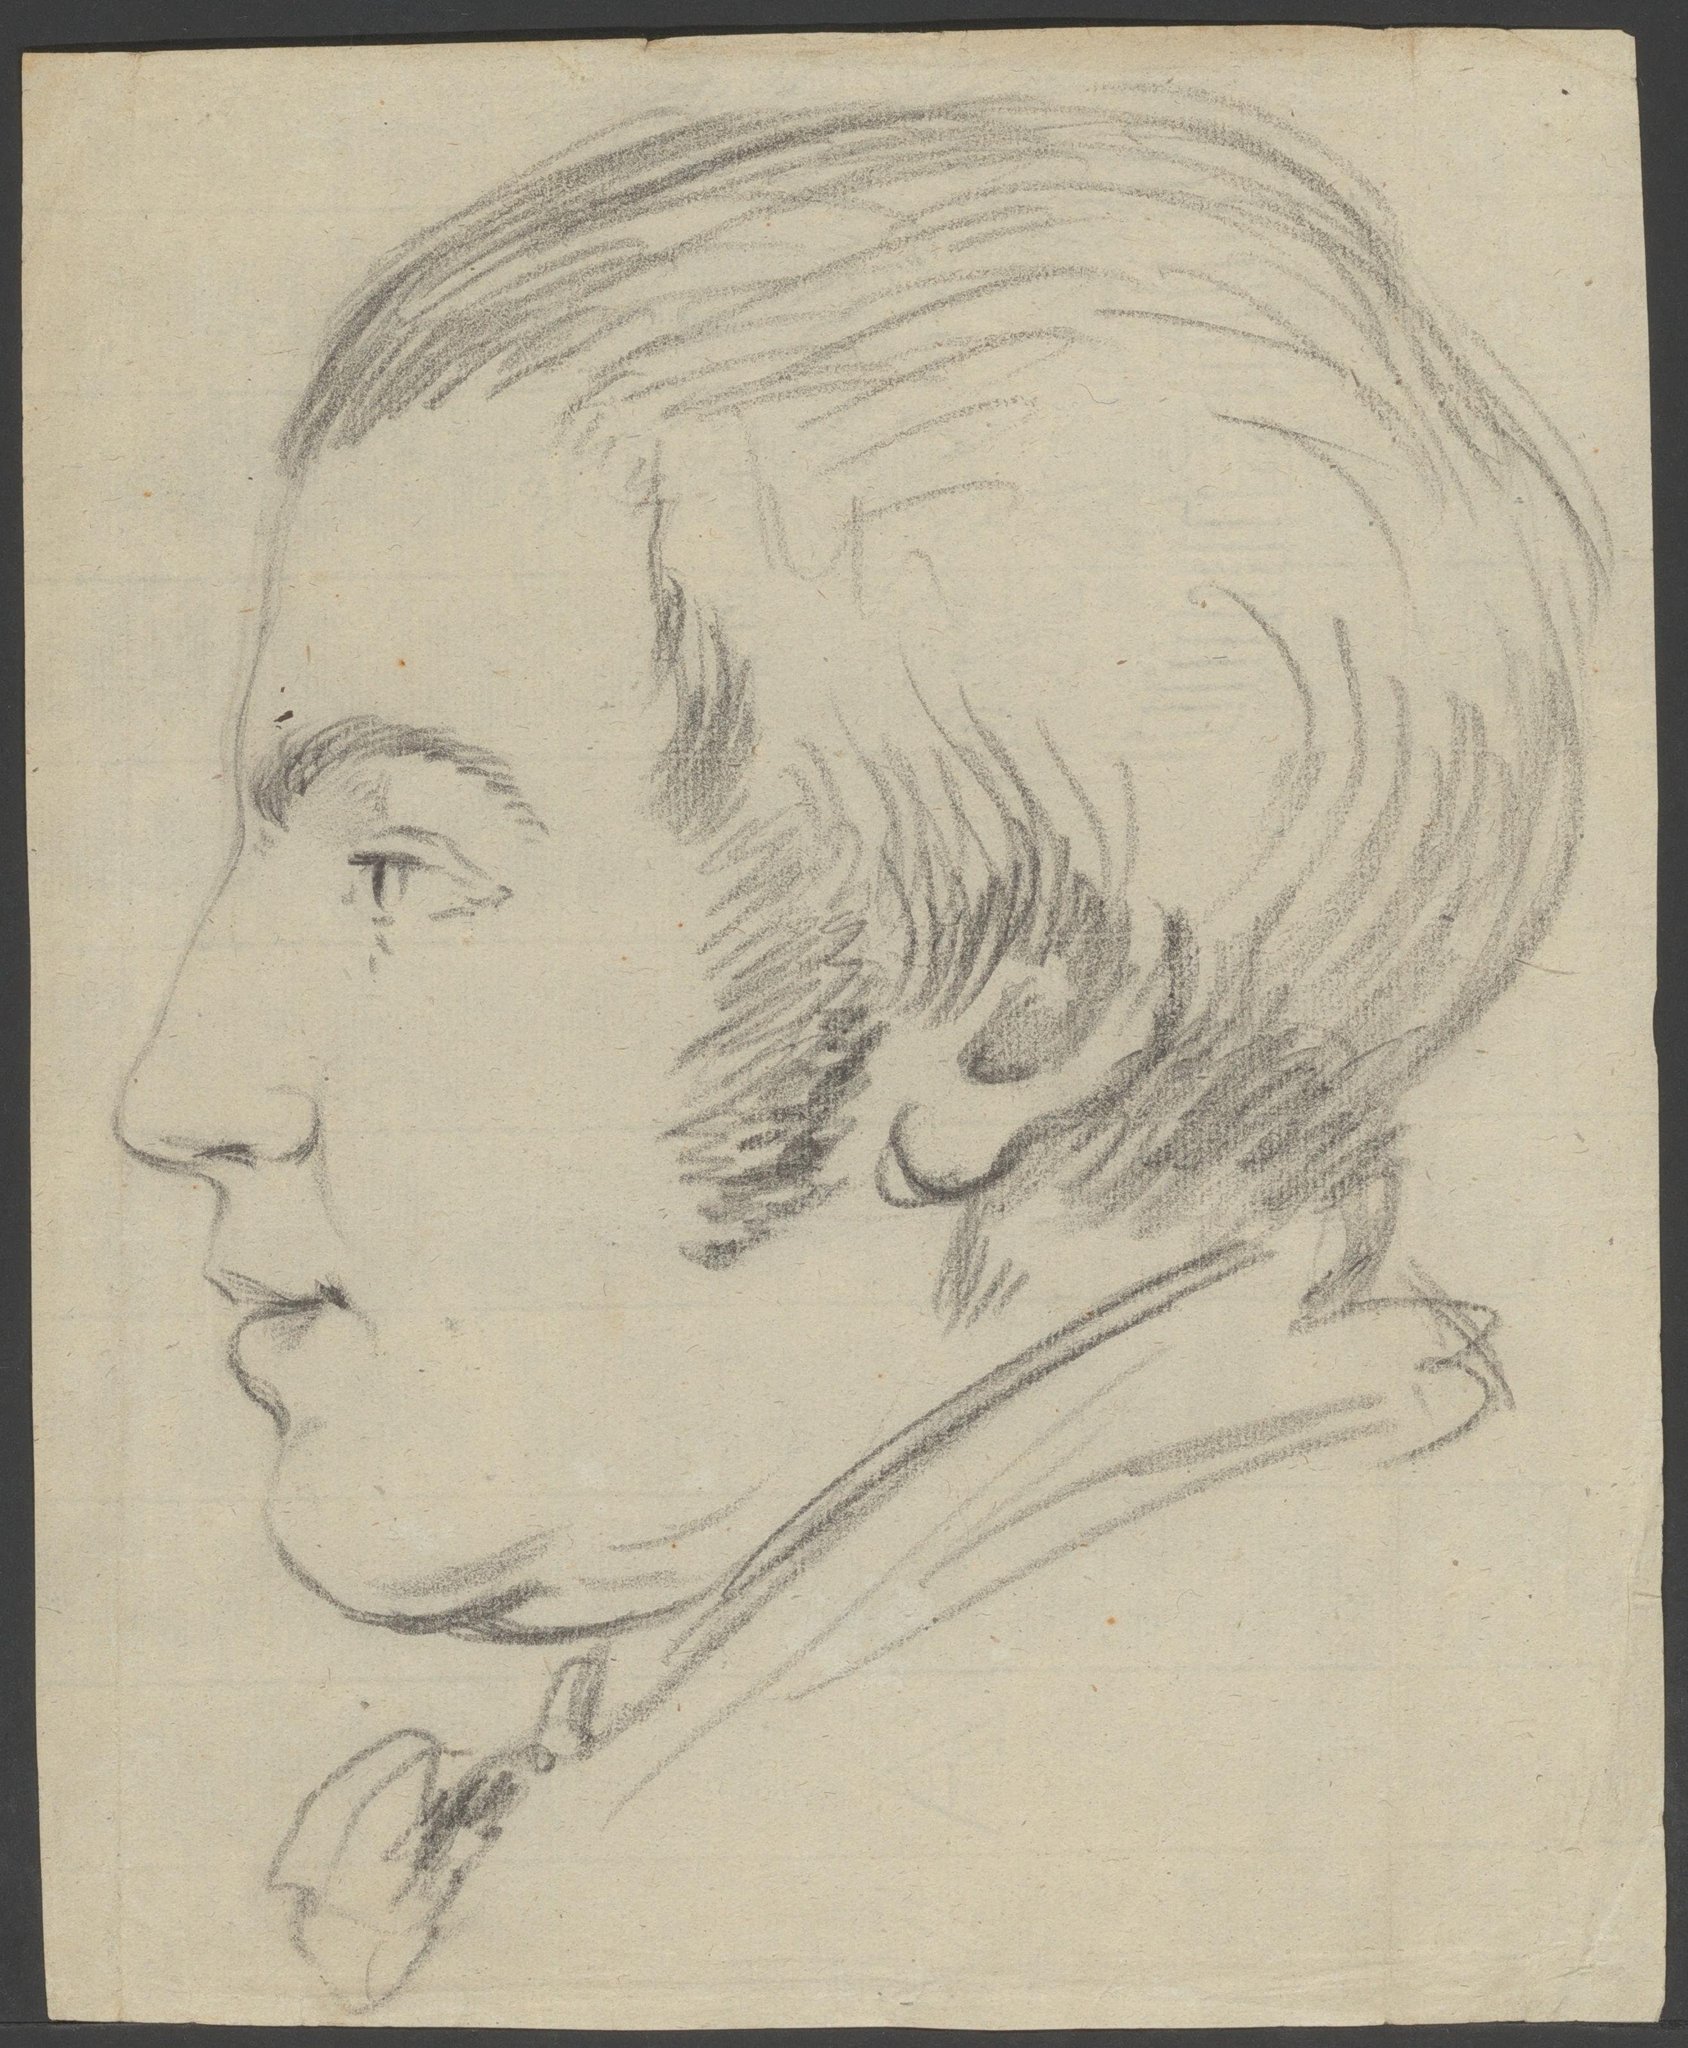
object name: drawing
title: Zijaanzicht van het gezicht van een jonge man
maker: jean bernard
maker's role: draughtsman, print maker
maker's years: 1765-1833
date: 1775-1833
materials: chalk, paper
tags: face (+ sideview, profile), youth, adolescent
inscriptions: collector's mark: Lugt 1641, stamp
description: Zijaanzicht van het gezicht van een jonge man. Onderwerpsrubrieken binnen de Atlas Zeden en Gewoonten: Schoone kunsten, Schilderkunst, Tekeningen.